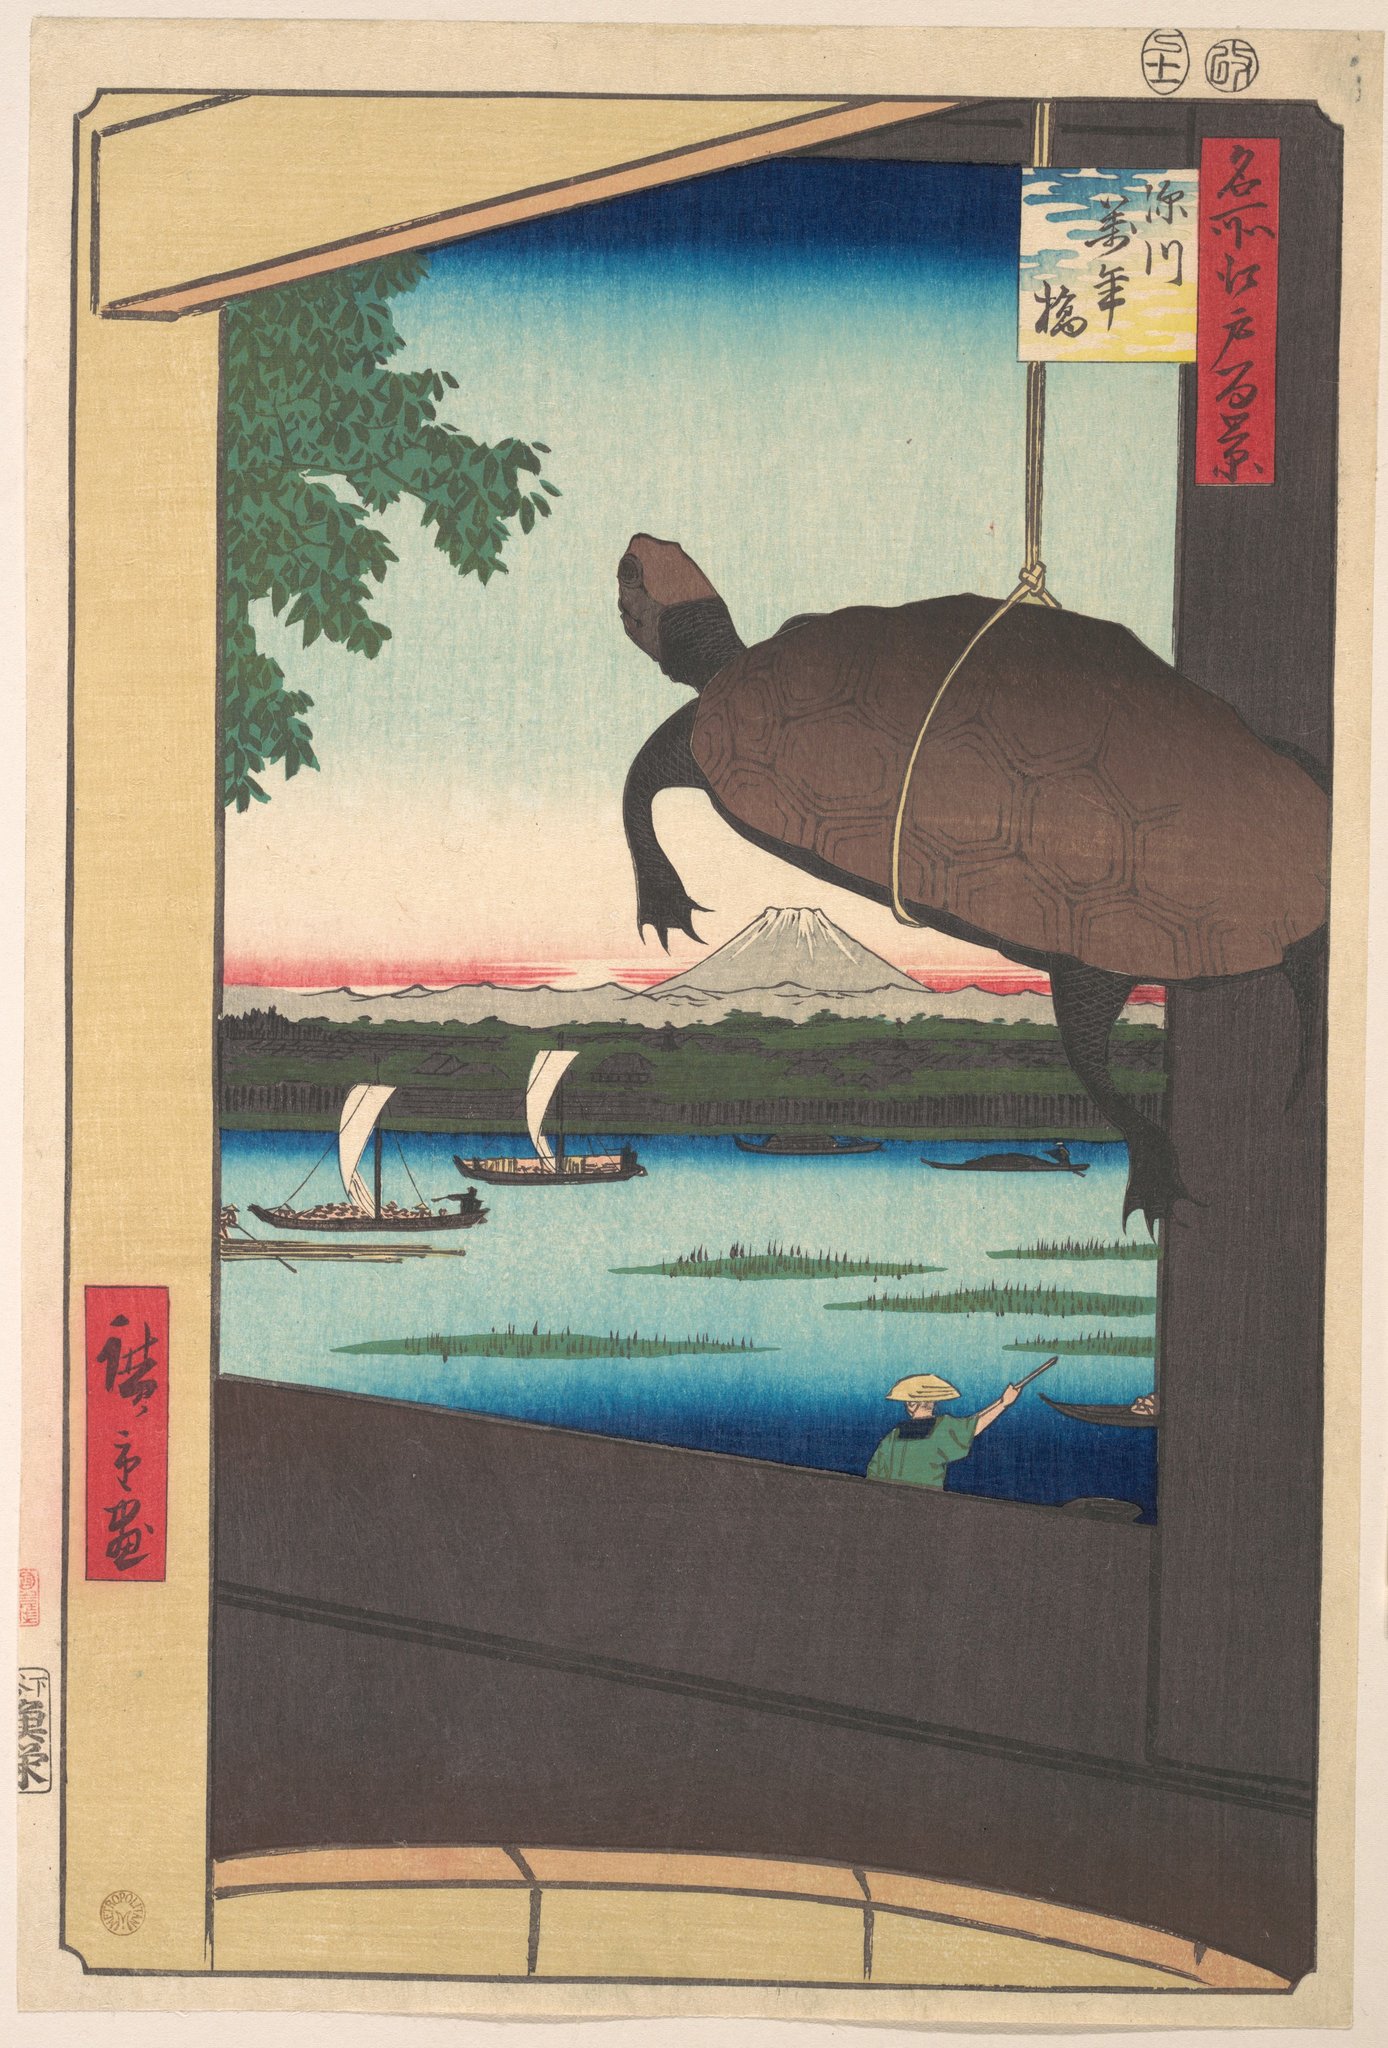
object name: print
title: Mannen Bridge, Fukagawa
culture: japanese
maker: utagawa hiroshige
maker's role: artist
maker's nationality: japanese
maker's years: 1797-1858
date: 1858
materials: ink, paper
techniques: woodblock print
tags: turtles,boats